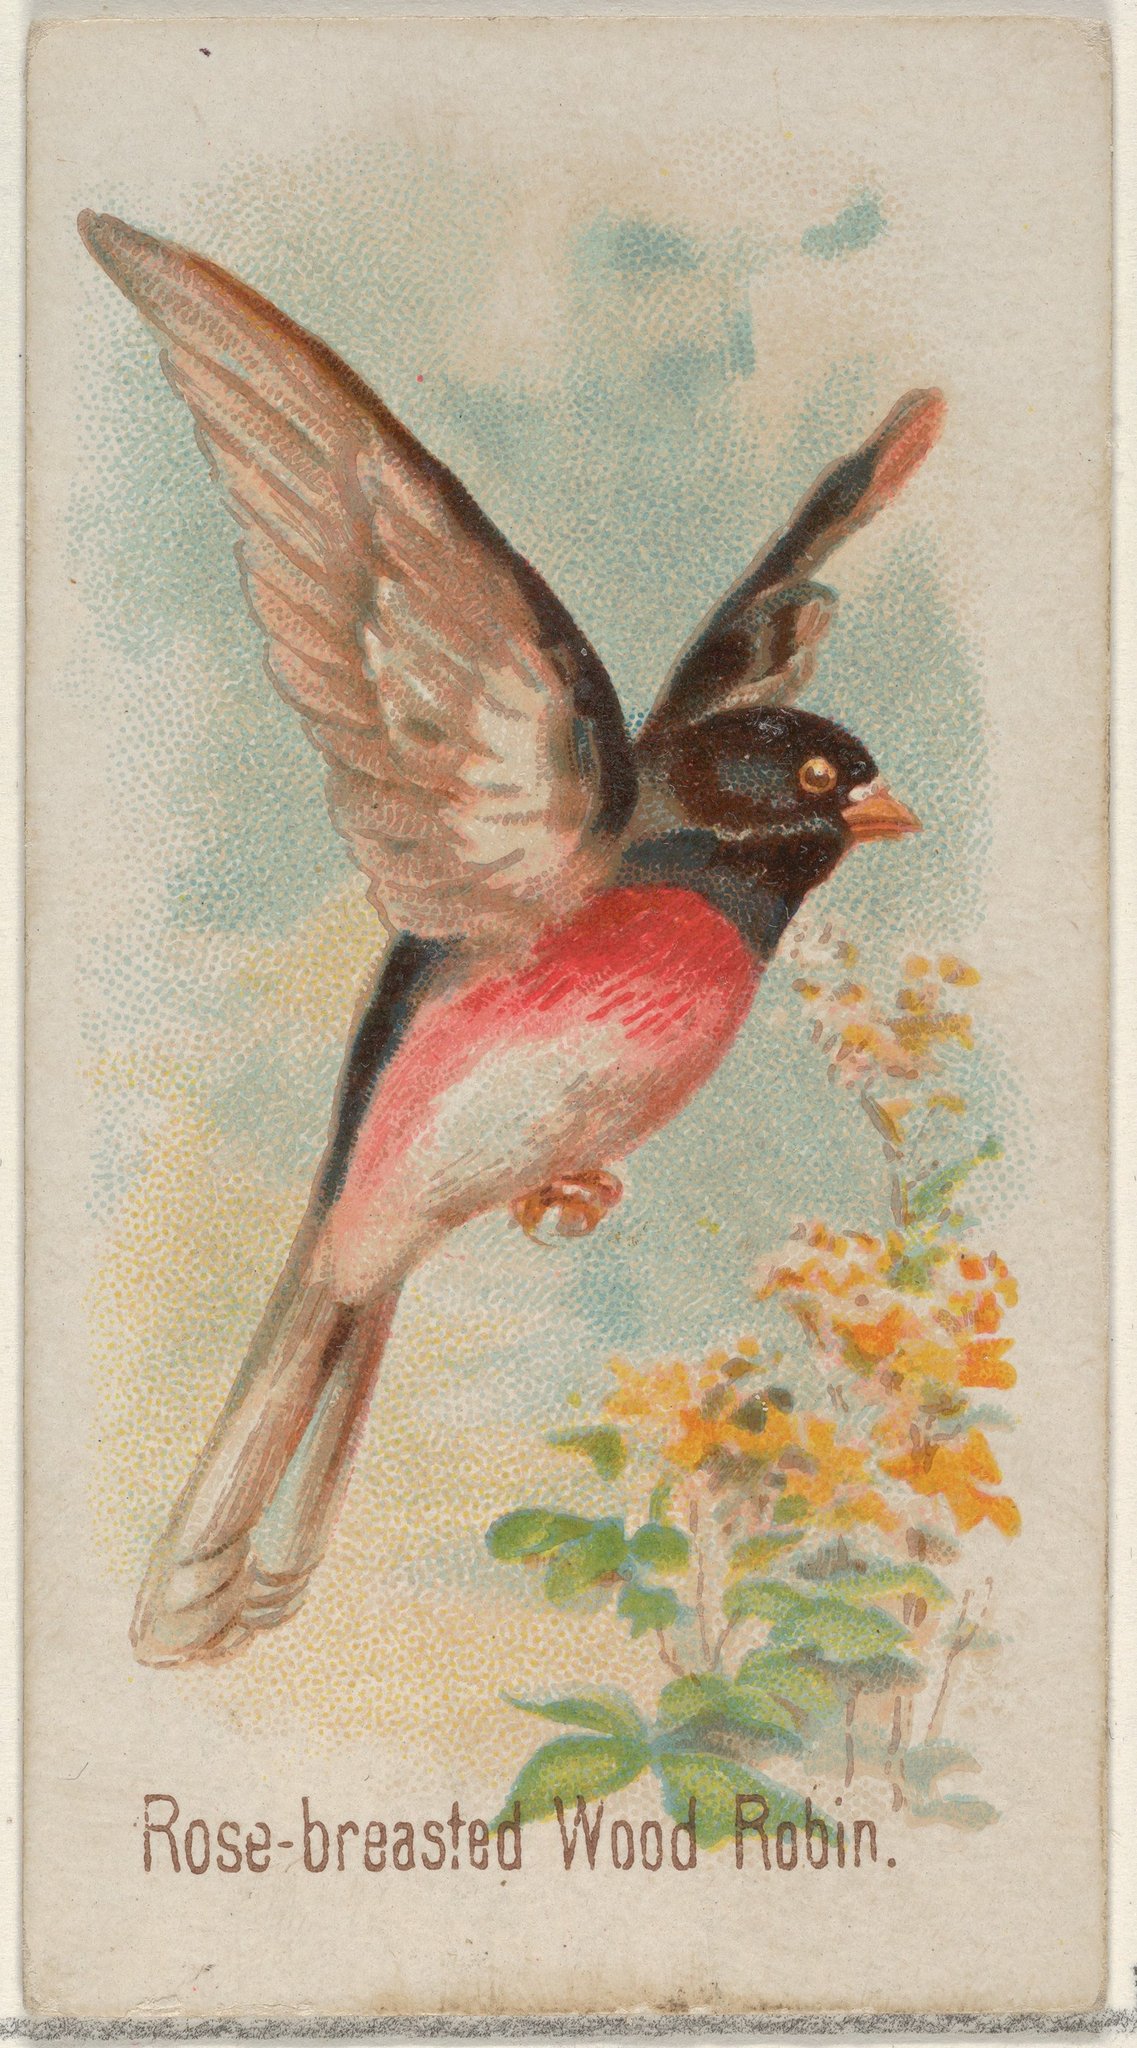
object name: print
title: Rose-breasted Wood Robin, from the Song Birds of the World series (N23) for Allen & Ginter Cigarettes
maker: allen & ginter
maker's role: publisher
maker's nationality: american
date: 1890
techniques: color lithograph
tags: birds